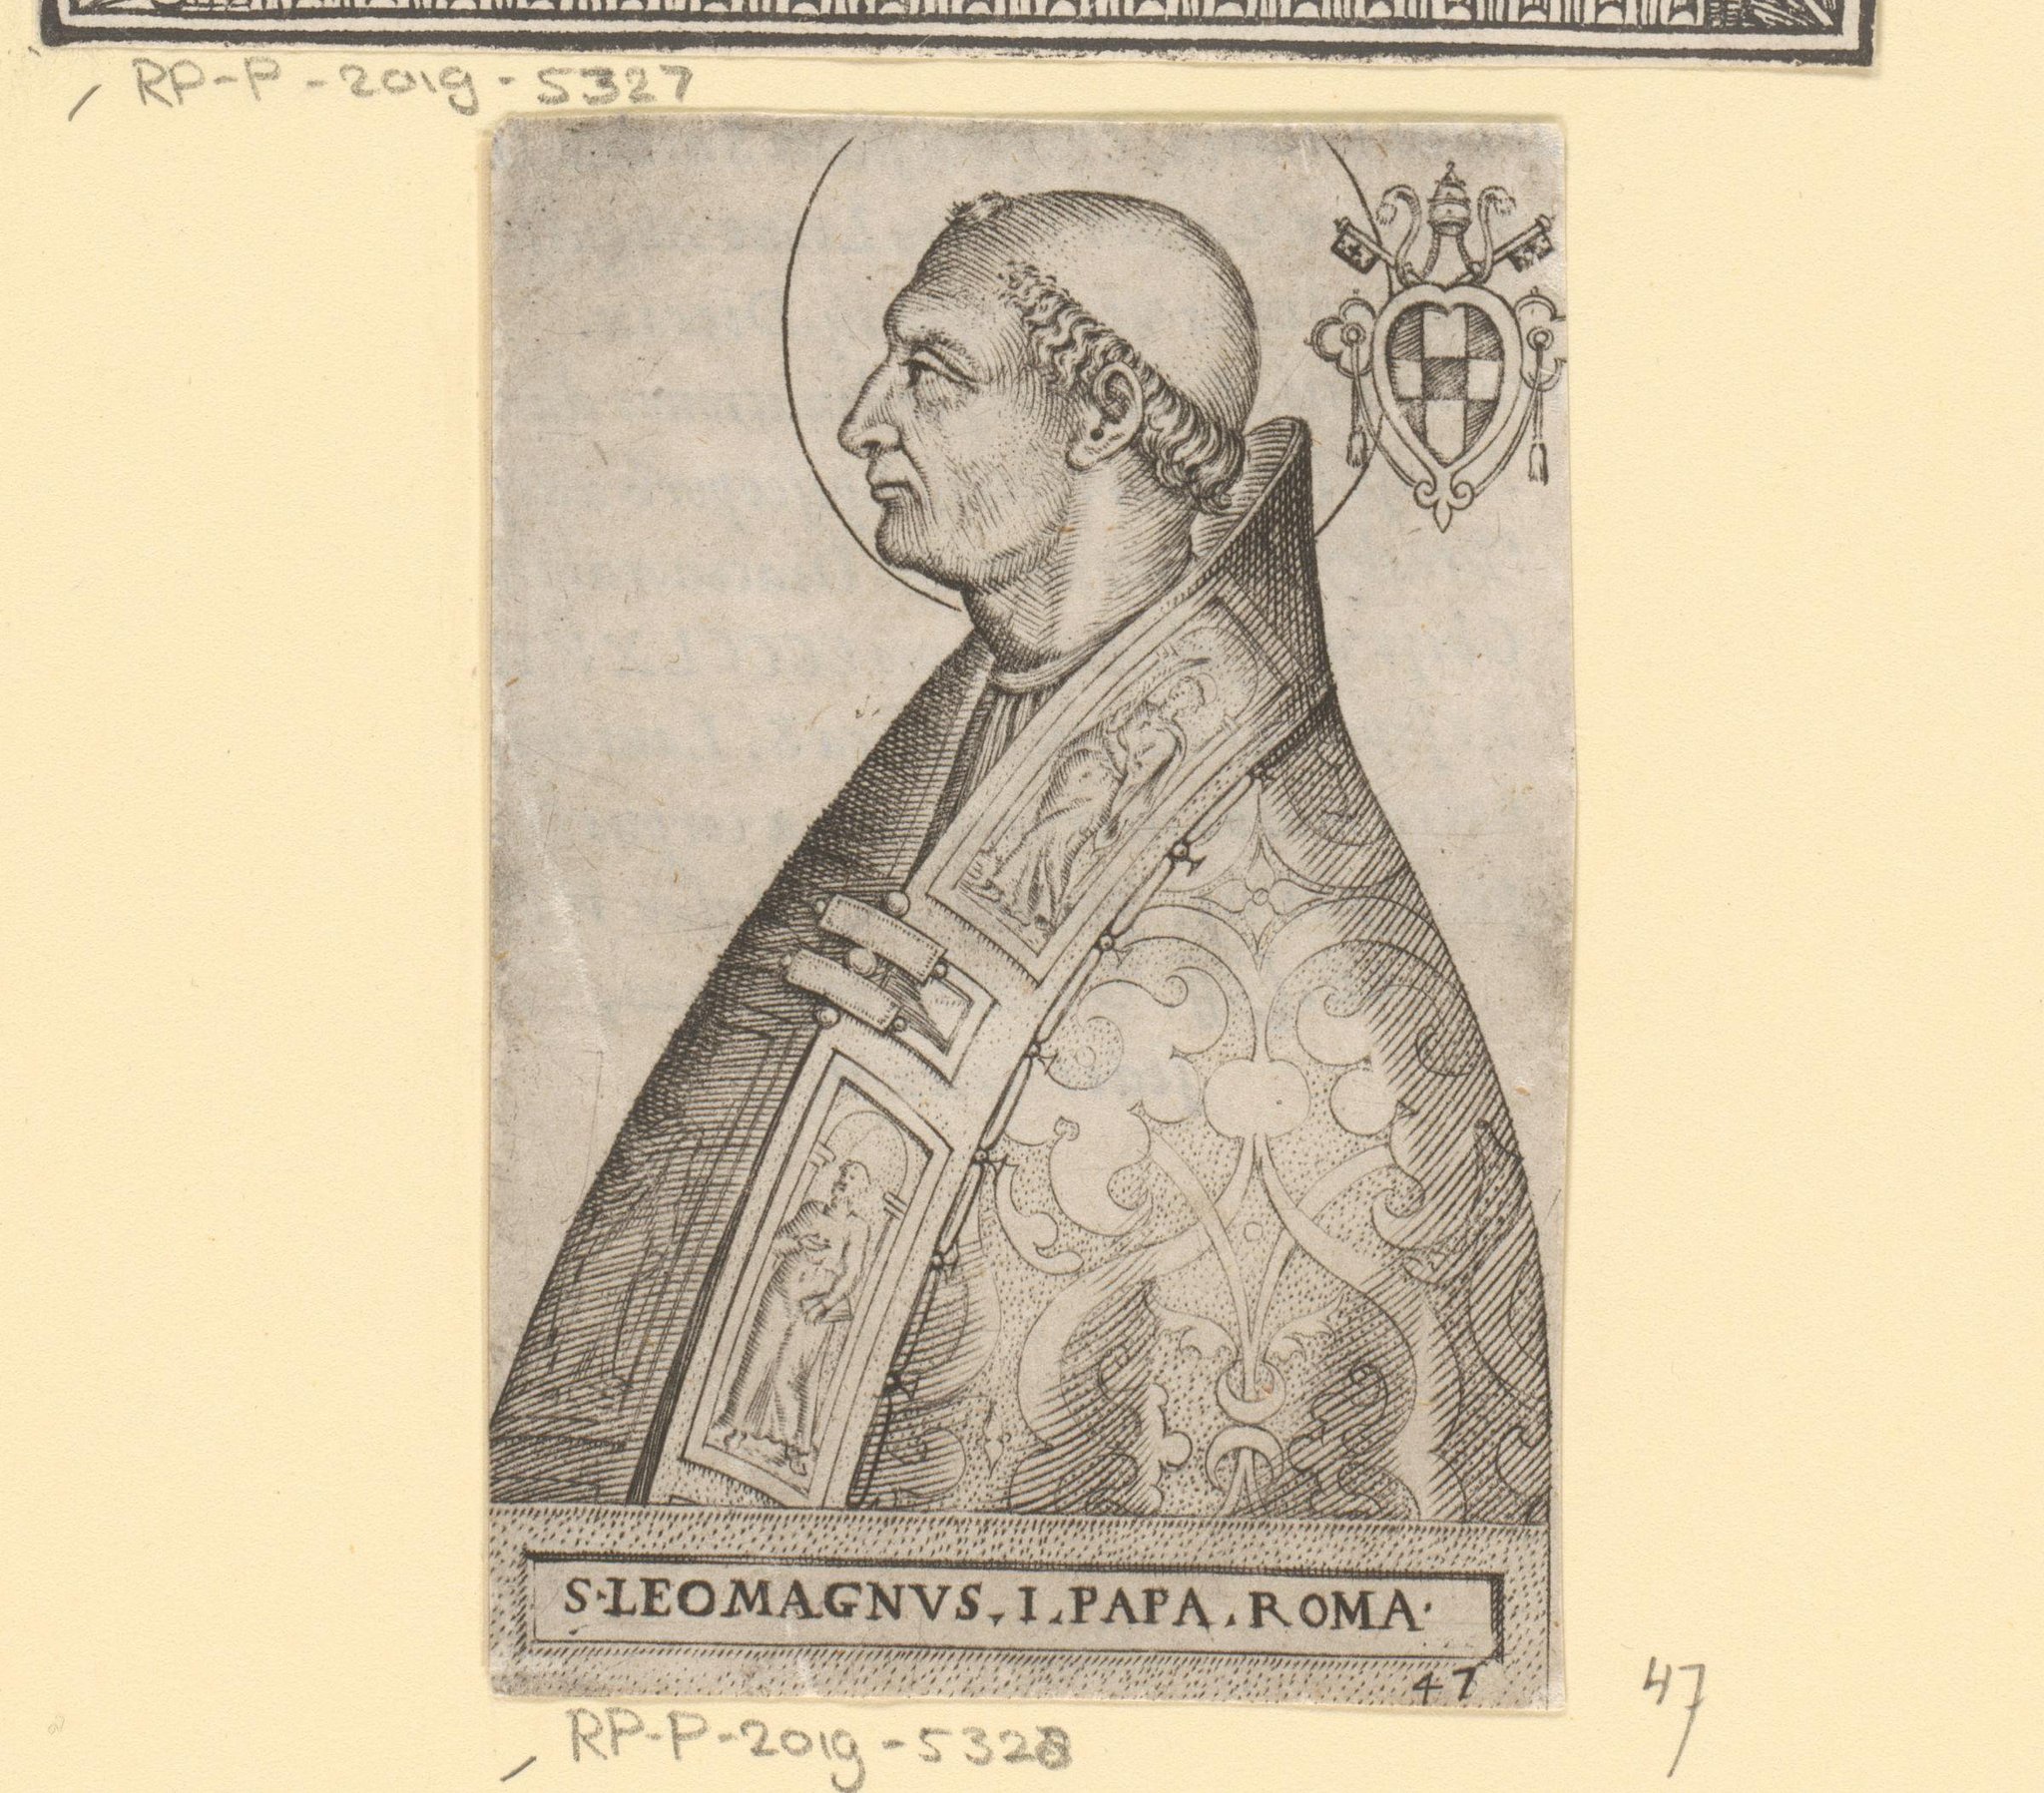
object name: book illustration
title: Portret van paus Leo I de Grote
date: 1595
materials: paper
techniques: engraving, letterpress printing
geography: rome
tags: historical persons, pope, armorial bearing, heraldry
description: Prent uit: Cavalieri, Giovanni Battista de'. Effigies pontificum romanorum cum eorum vitis (...). Rome: Bartolomeo Bonfadino, 1595. Prent voor het eerst verschenen in: Cavalieri, Giovanni Battista de'. Pontificum romanorum effigies (...). Rome: Domenico Basa en Francesco Zanetti, 1580. Prent ook gebruikt in latere publicaties.